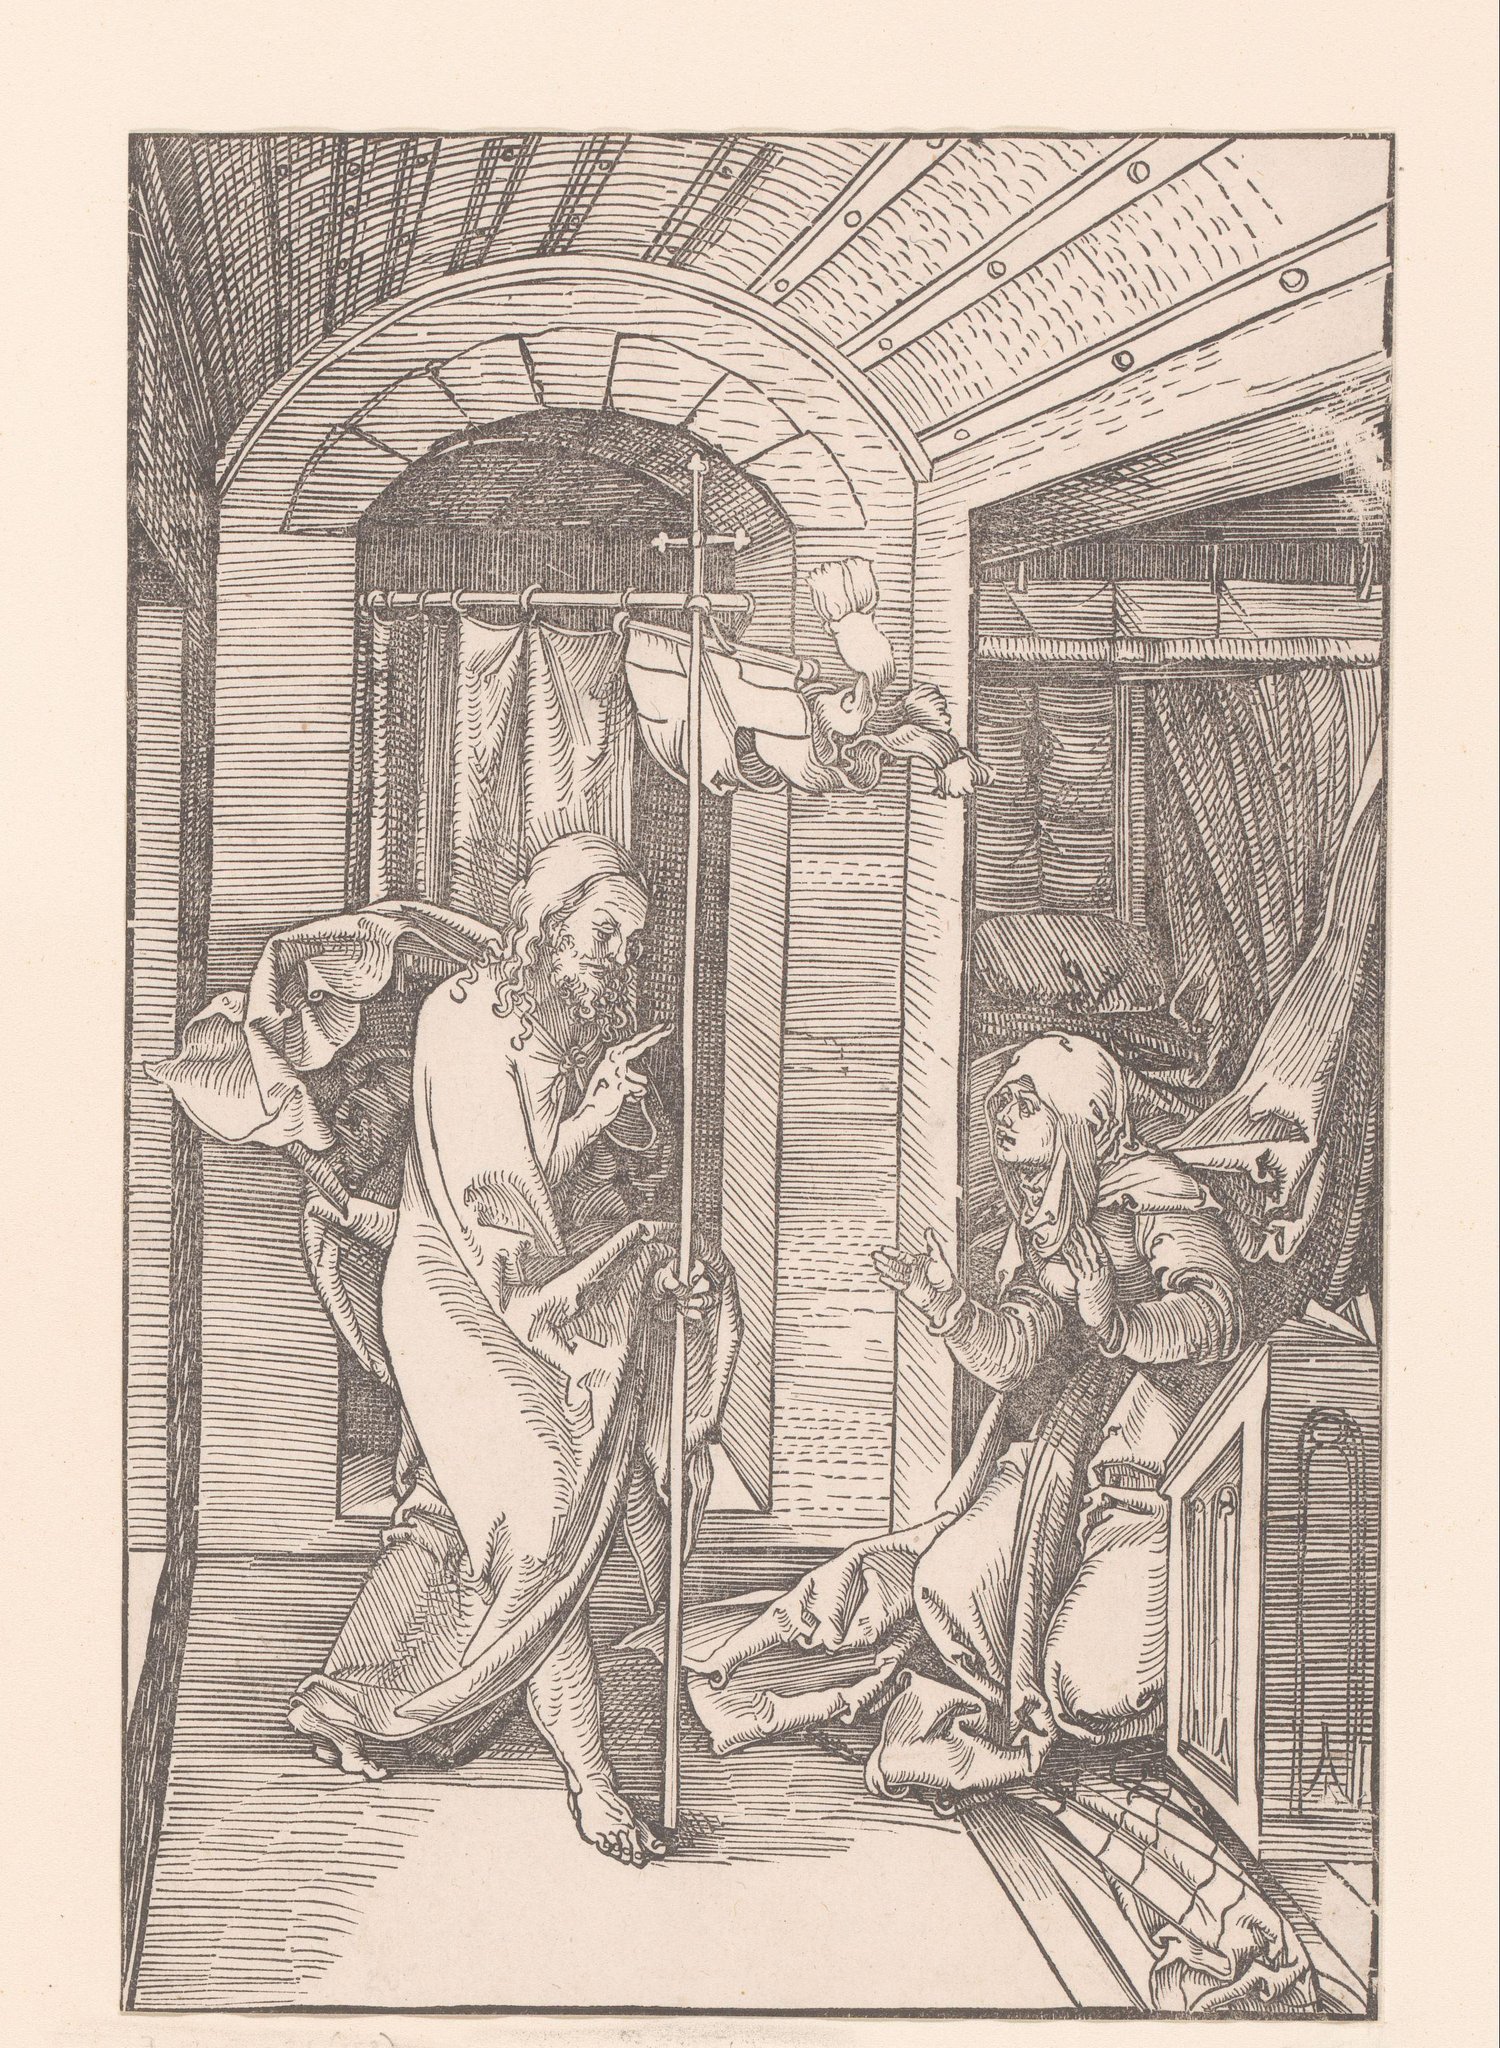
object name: book illustration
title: Christus verschijnt aan zijn moeder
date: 1506-1507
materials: paper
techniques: woodcut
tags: christ, perhaps dressed as a pilgrim, appearing to his mother, who is usually shown praying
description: Prent voor het eerst gebruikt in: Speculum Passionis. Neurenberg: Ulrich Pinder, 1507.